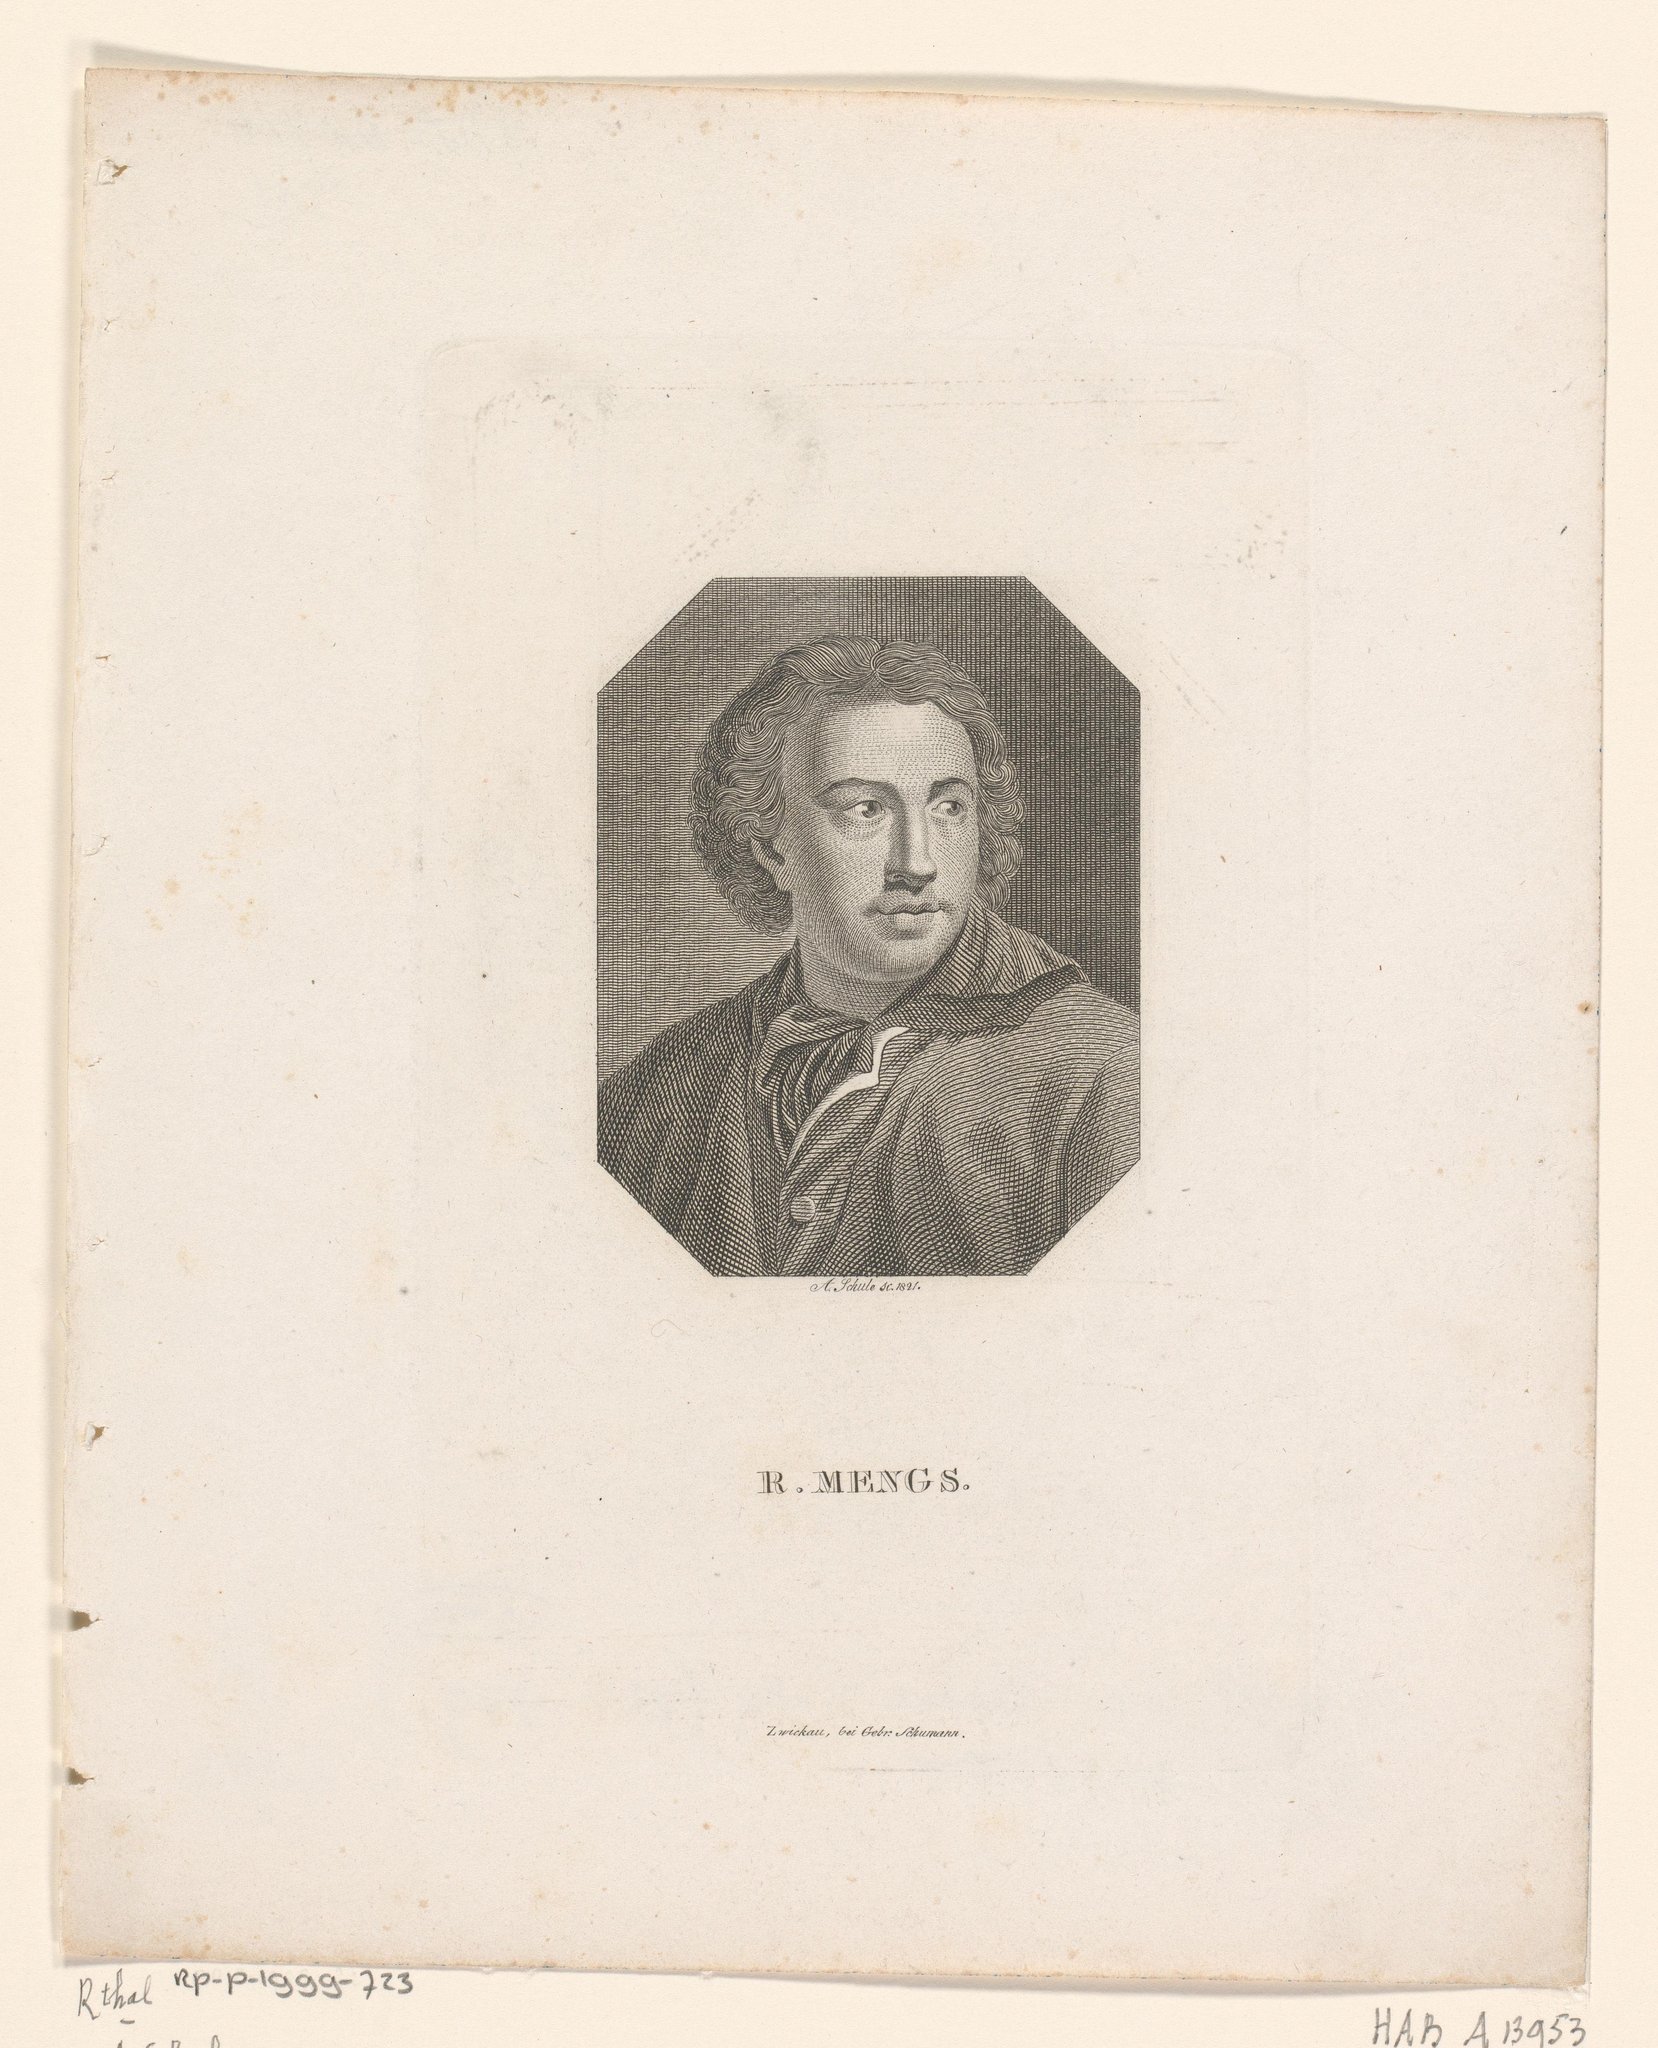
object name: print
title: Portret Anton Raphael Mengs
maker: albert schule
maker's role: painter, print maker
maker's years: 1801-1875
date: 1821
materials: paper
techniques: engraving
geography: zwickau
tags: rome, painter, draughtsman, anton raphael mengs, historical persons, portrait, self-portrait of artist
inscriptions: collector's mark: Lugt 2228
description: Portret van de schilder Anton Raphael Mengs: buste naar rechts kijkend.